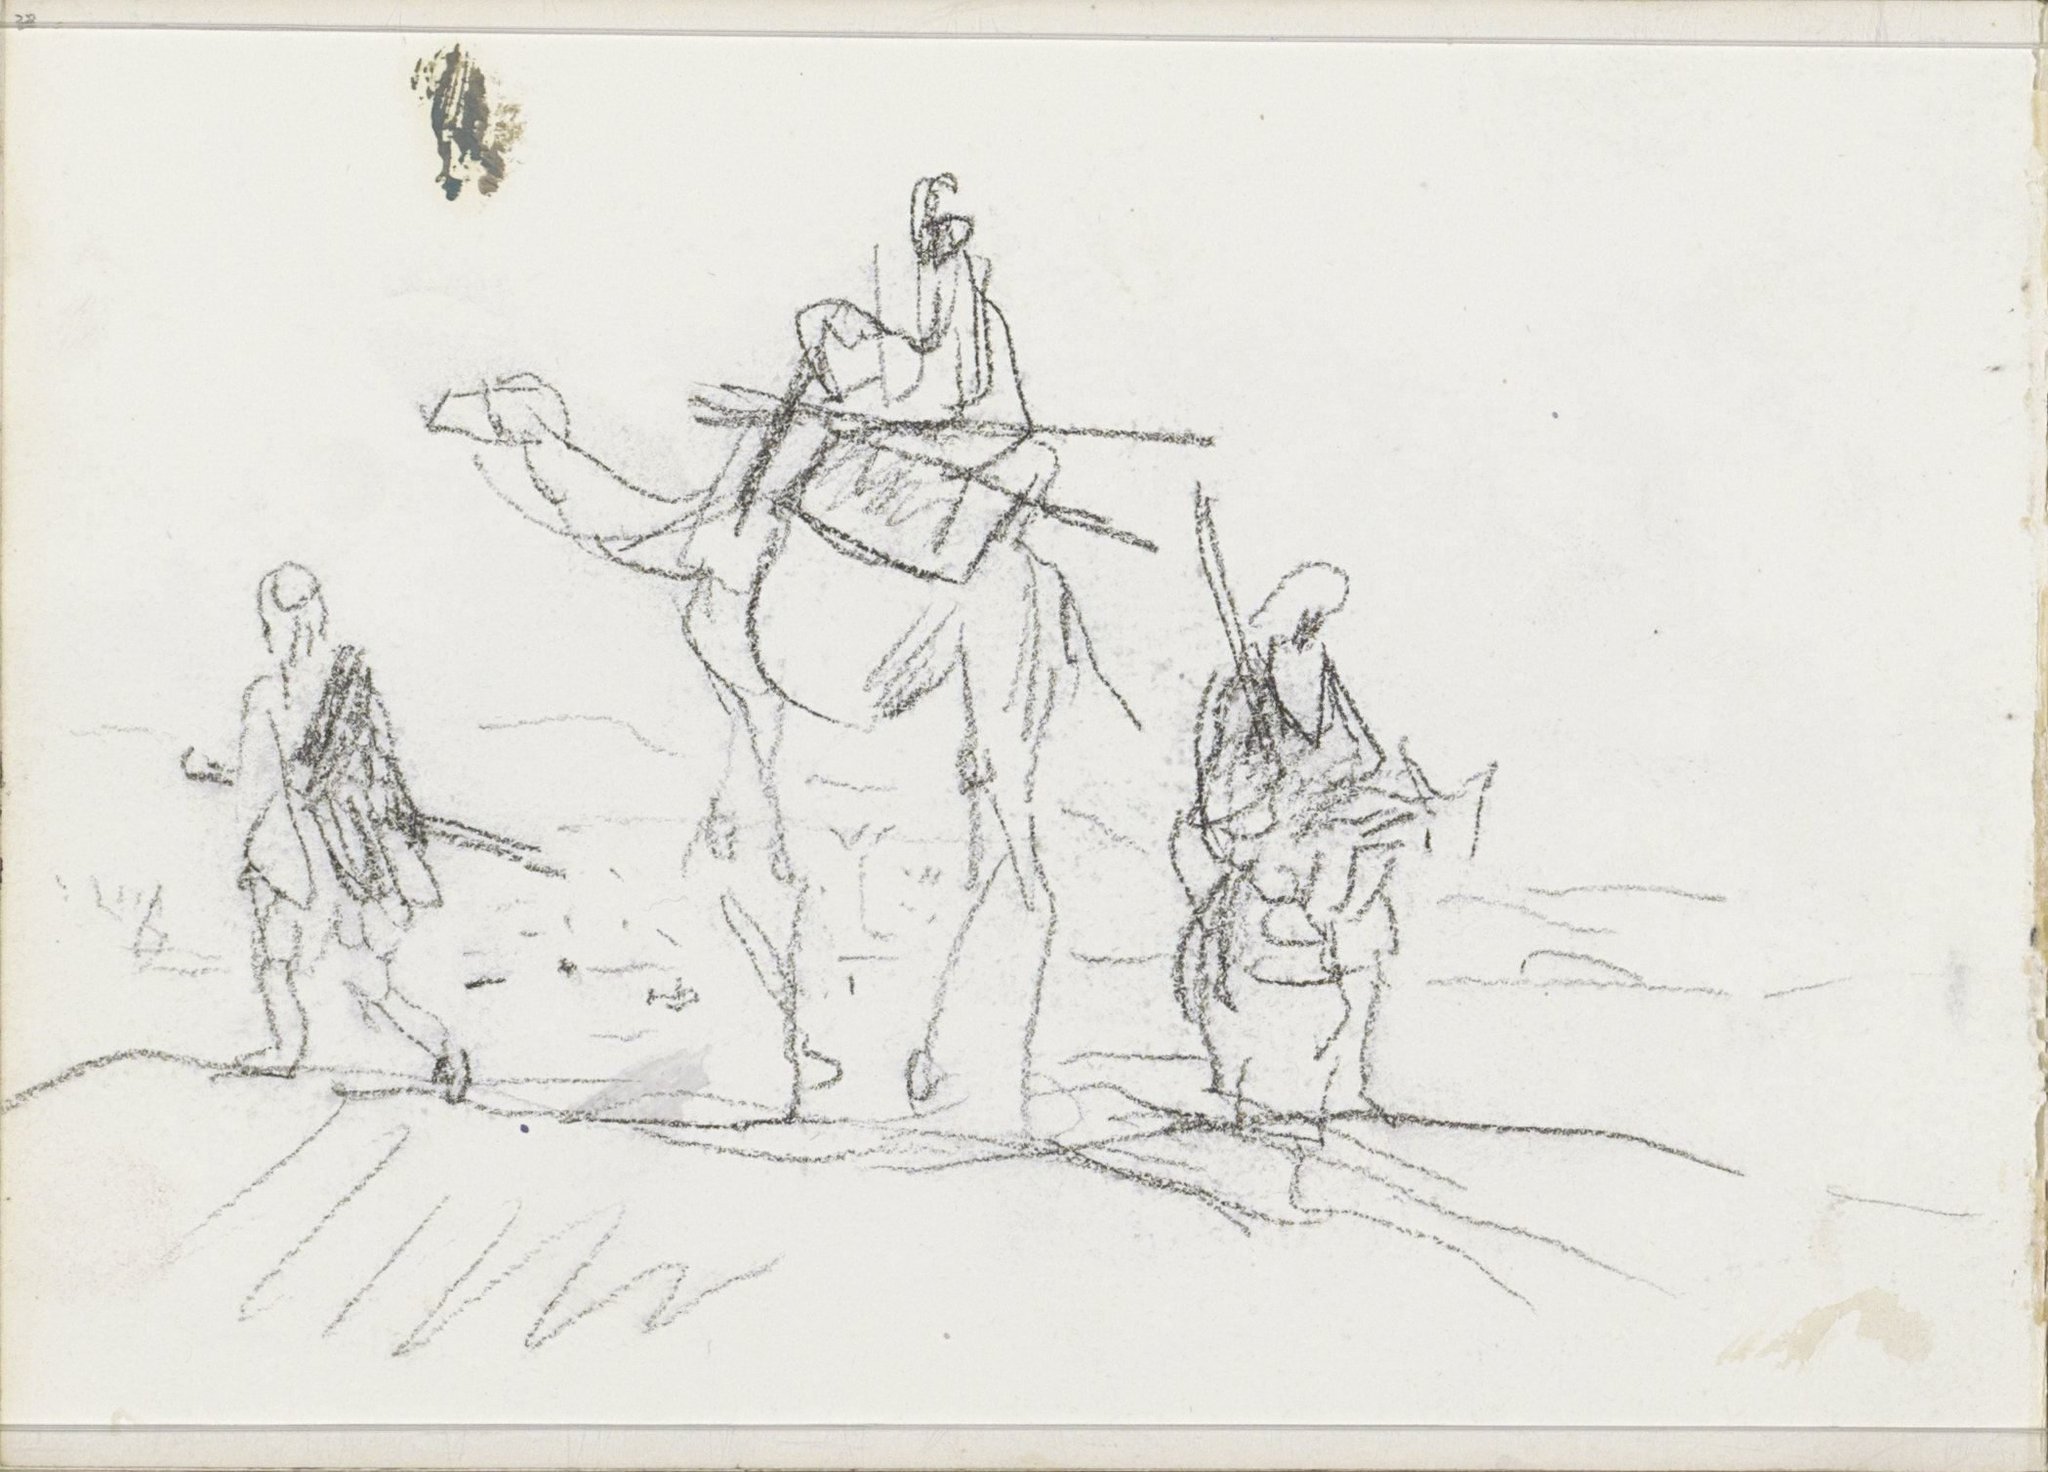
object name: sketchbook leaf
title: Woestijnlandschap met figuren op een kameel en ezel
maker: marius bauer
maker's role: draughtsman, print maker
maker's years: 1867-1932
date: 1919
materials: chalk, paper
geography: egypt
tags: riding a horse, ass, or mule; rider, horseman, hoofed animals: camel, desert, landscapes (+ landscape with figures, staffage)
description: Pagina 38 uit een schetsboek met 23 bladen.